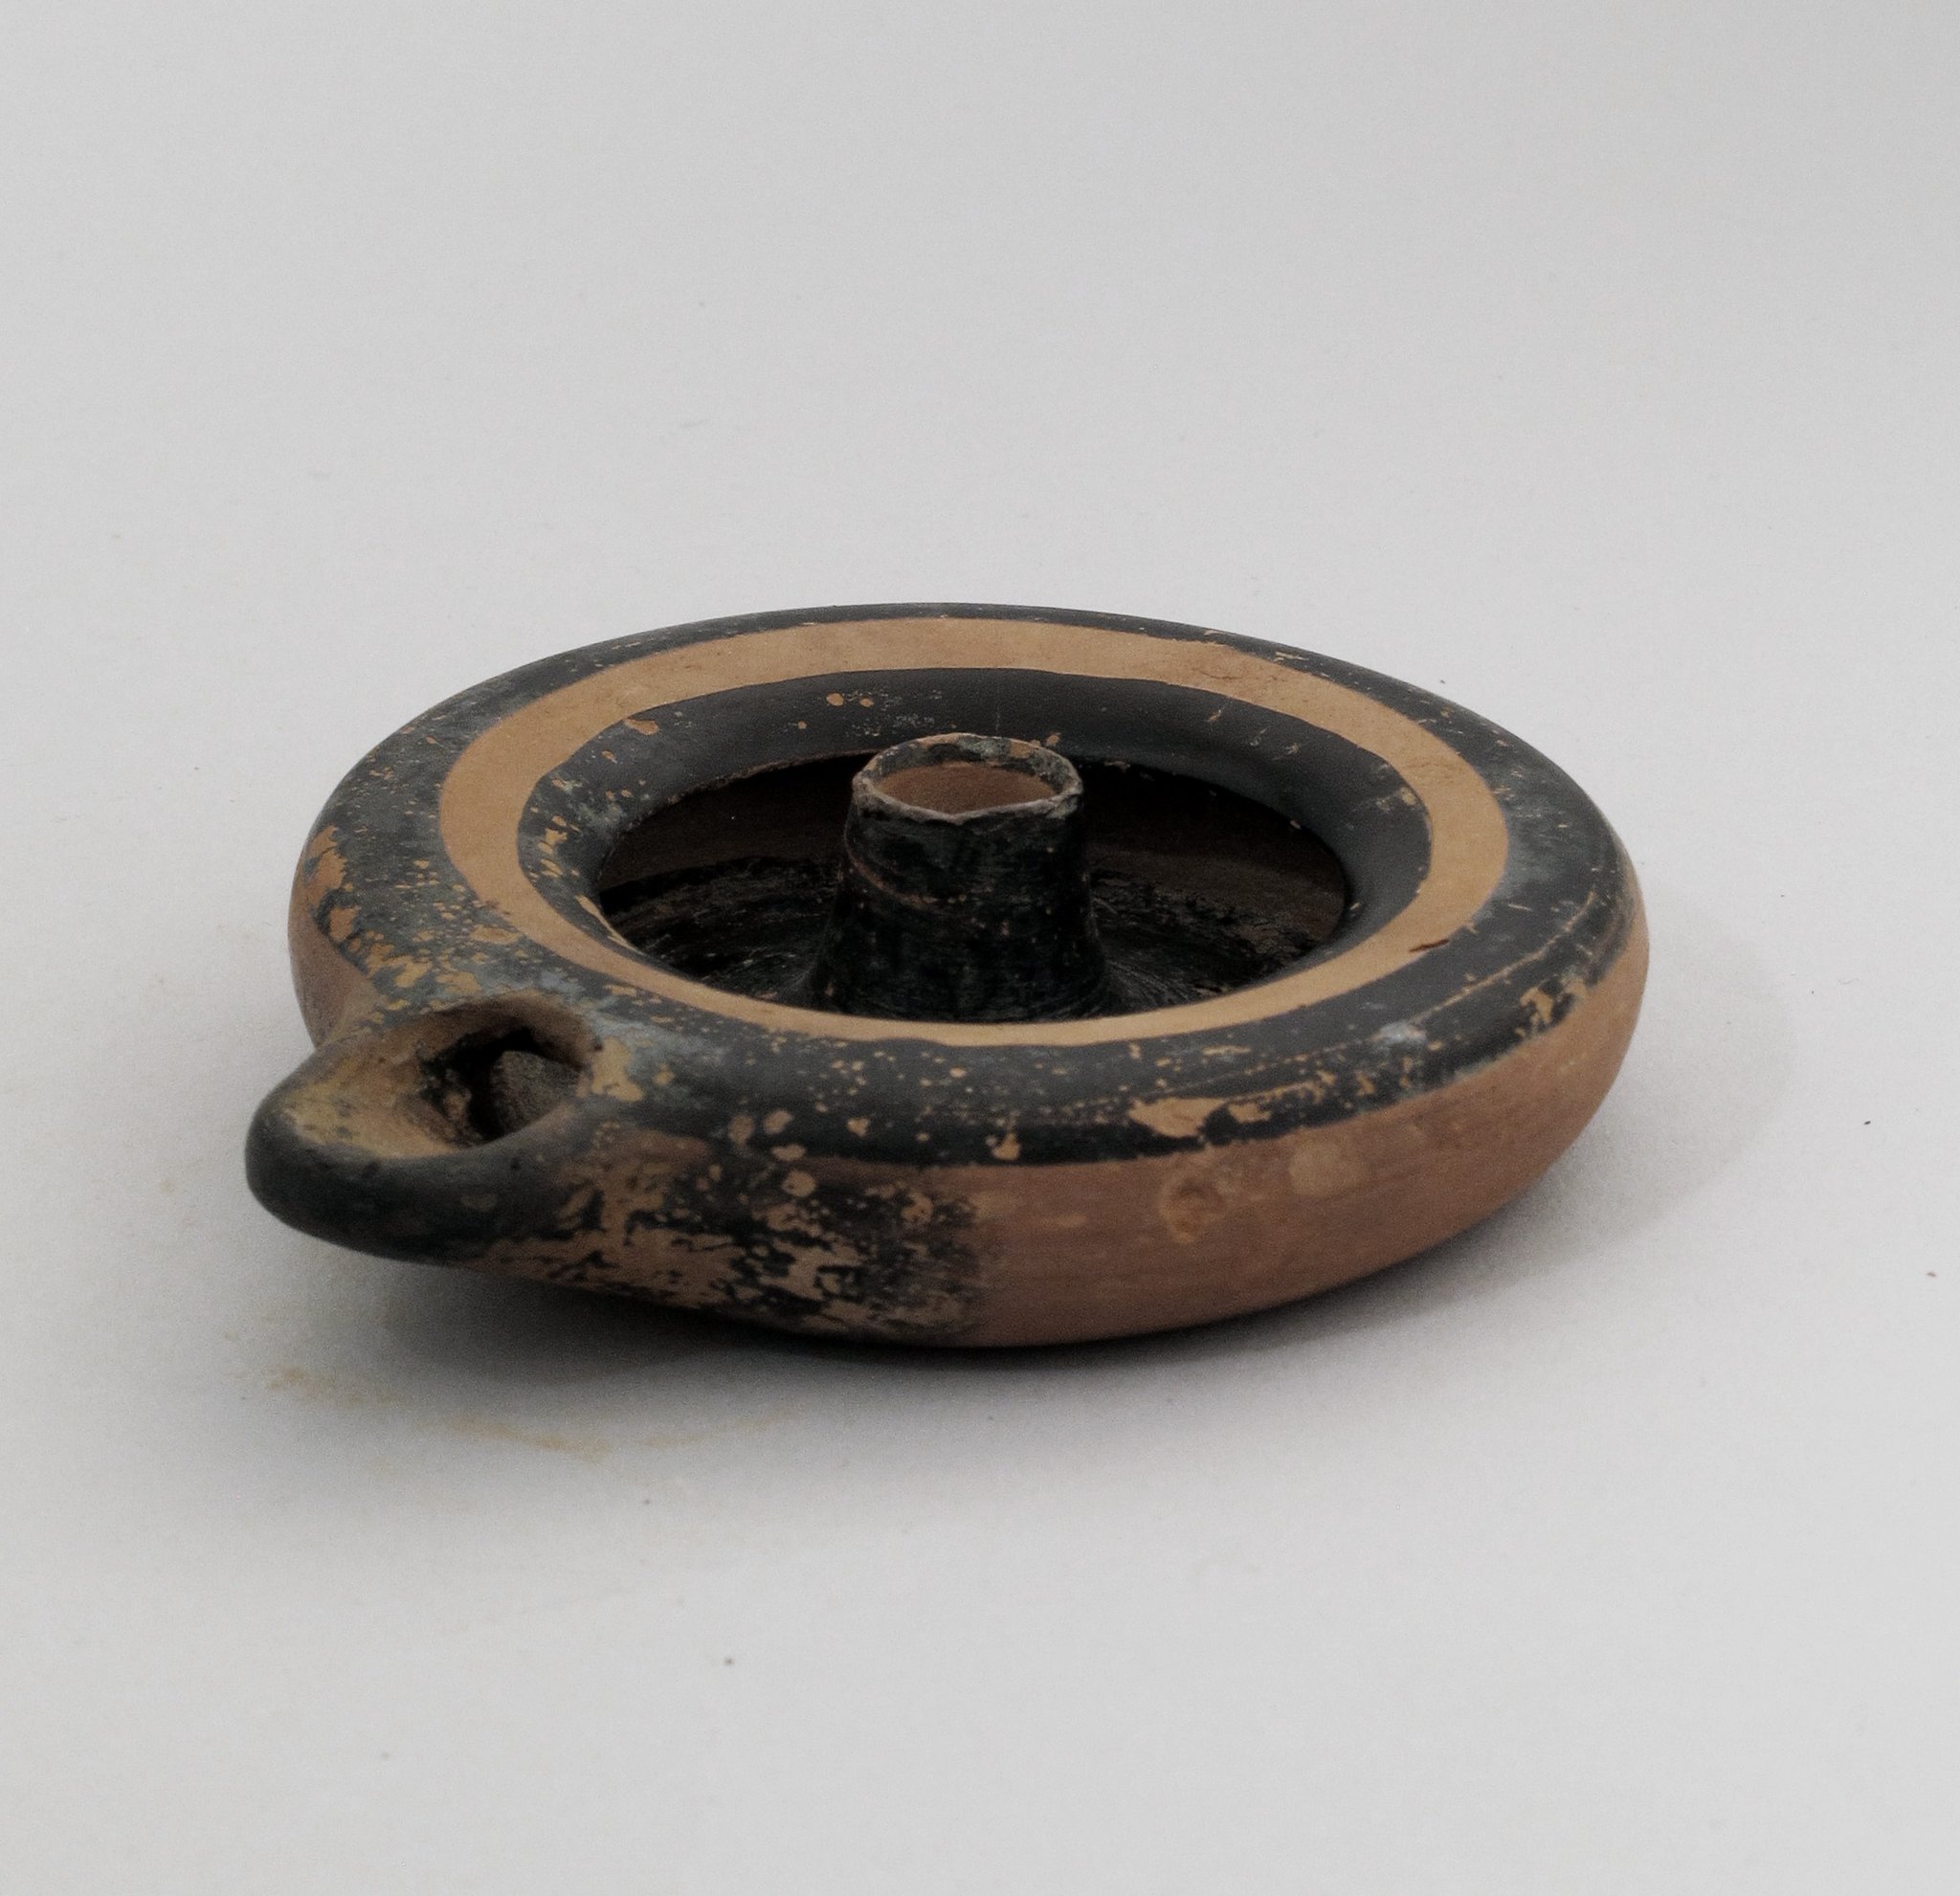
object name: lamp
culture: greek, attic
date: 500-460 BCE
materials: terracotta